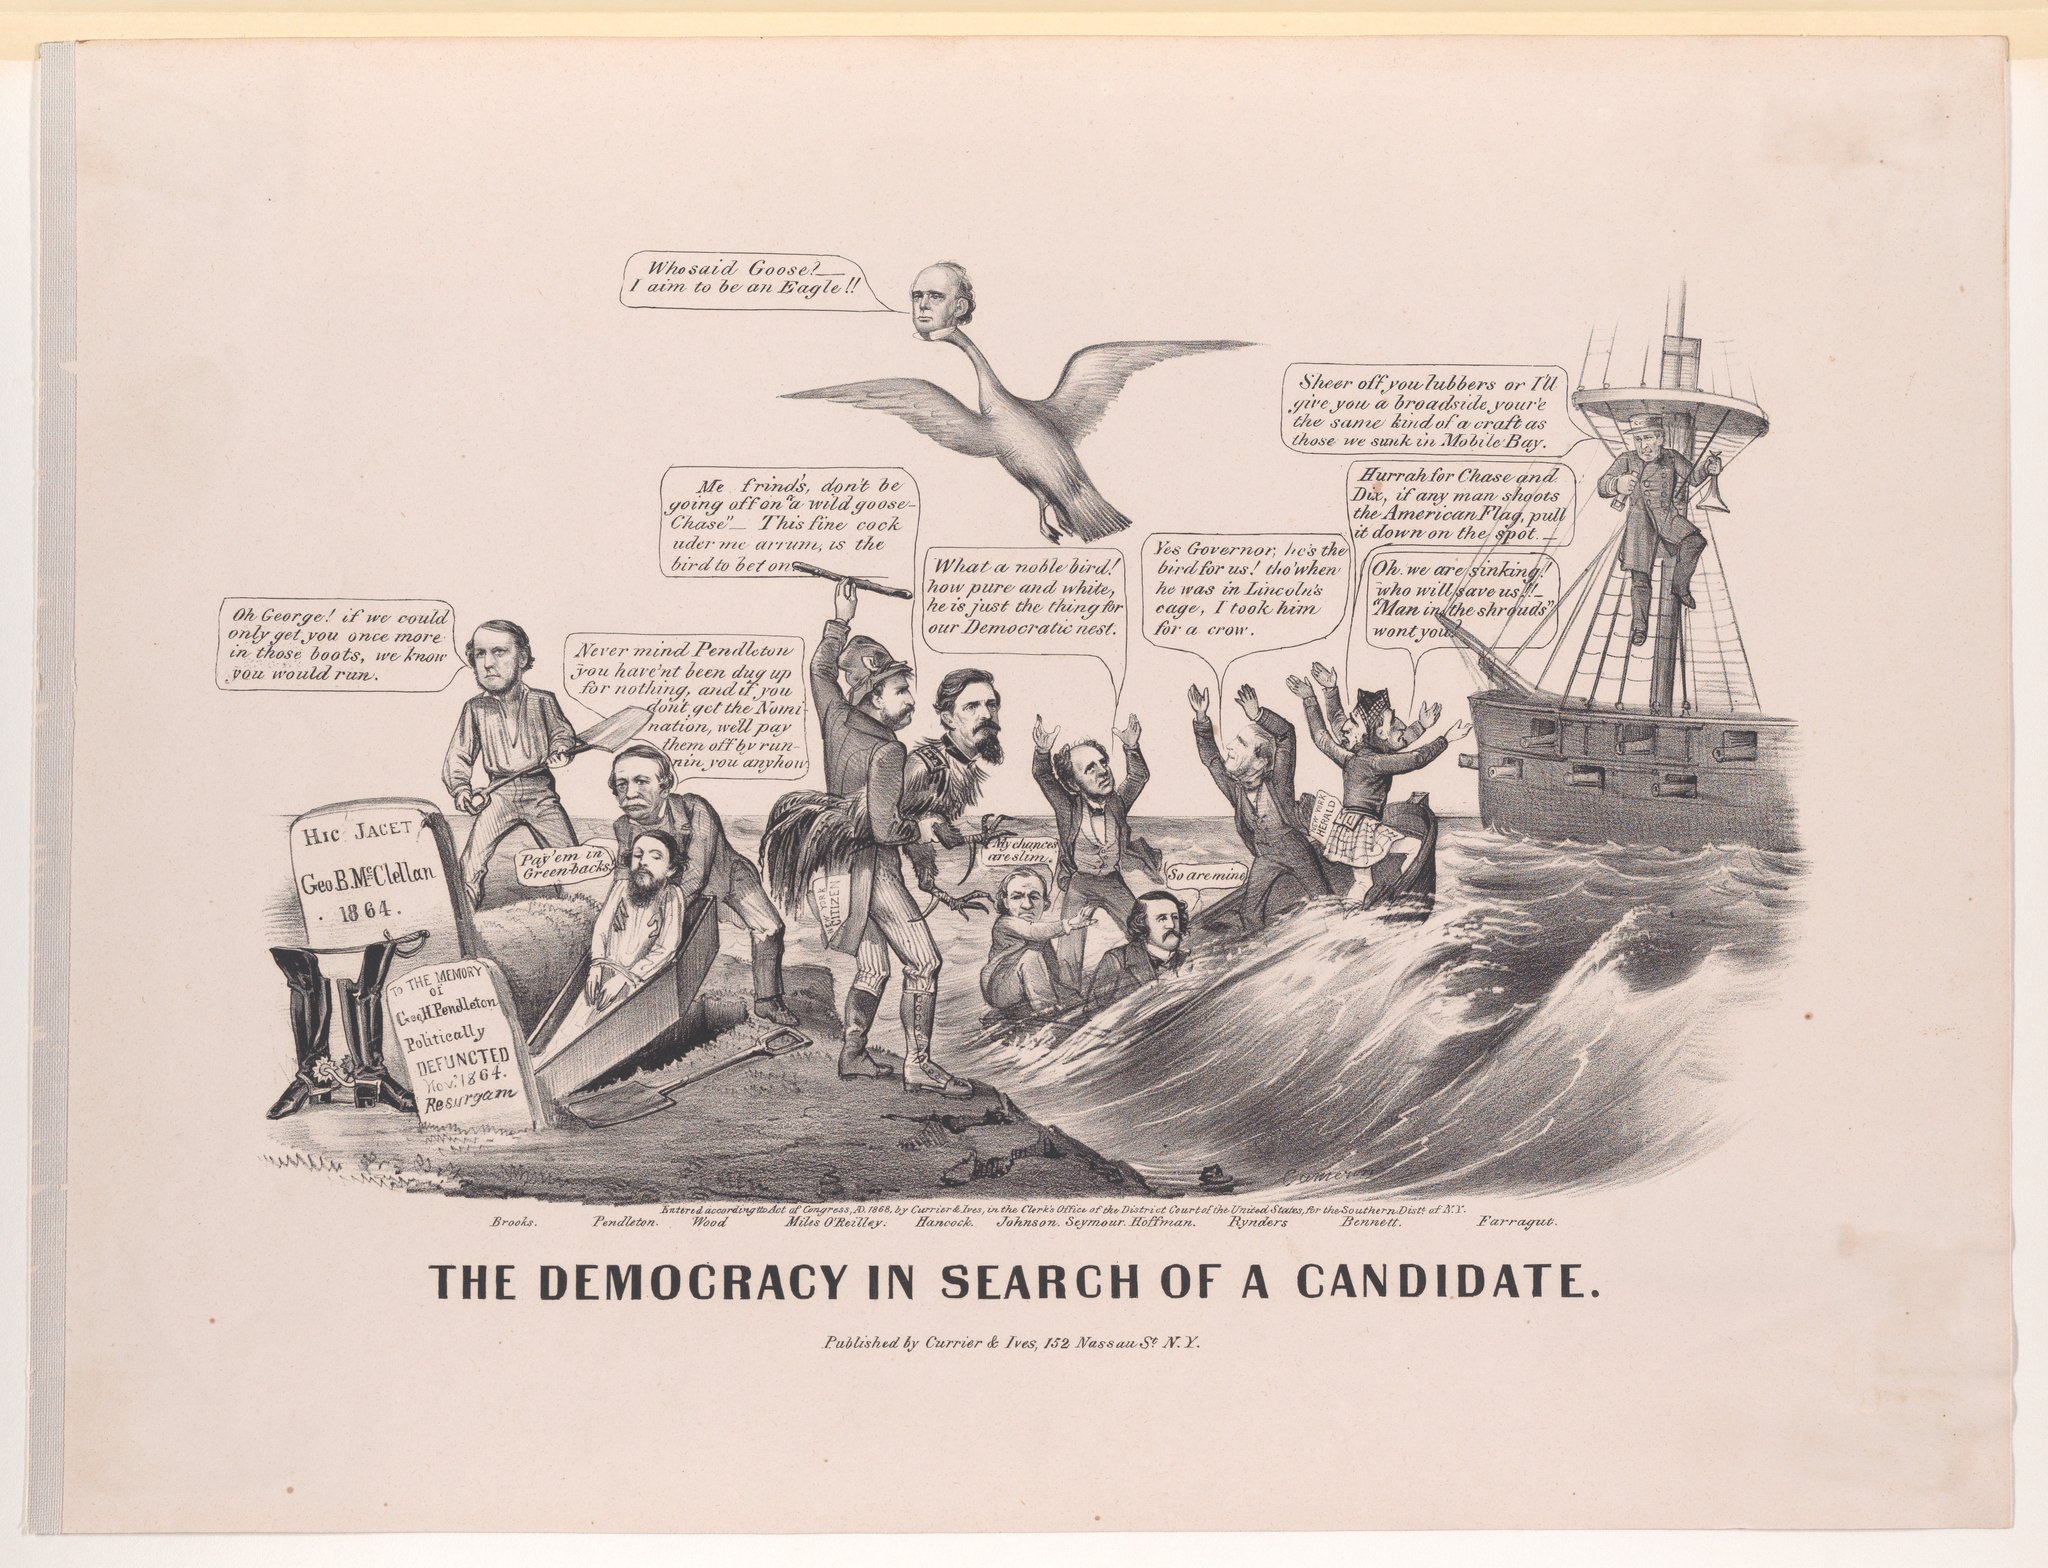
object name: print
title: The Democracy in Search of a Candidate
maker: john cameron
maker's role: artist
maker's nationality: american, born scotland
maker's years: 1828-1896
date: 1868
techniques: lithograph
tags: birds,satire,men,coffins,boats,politics